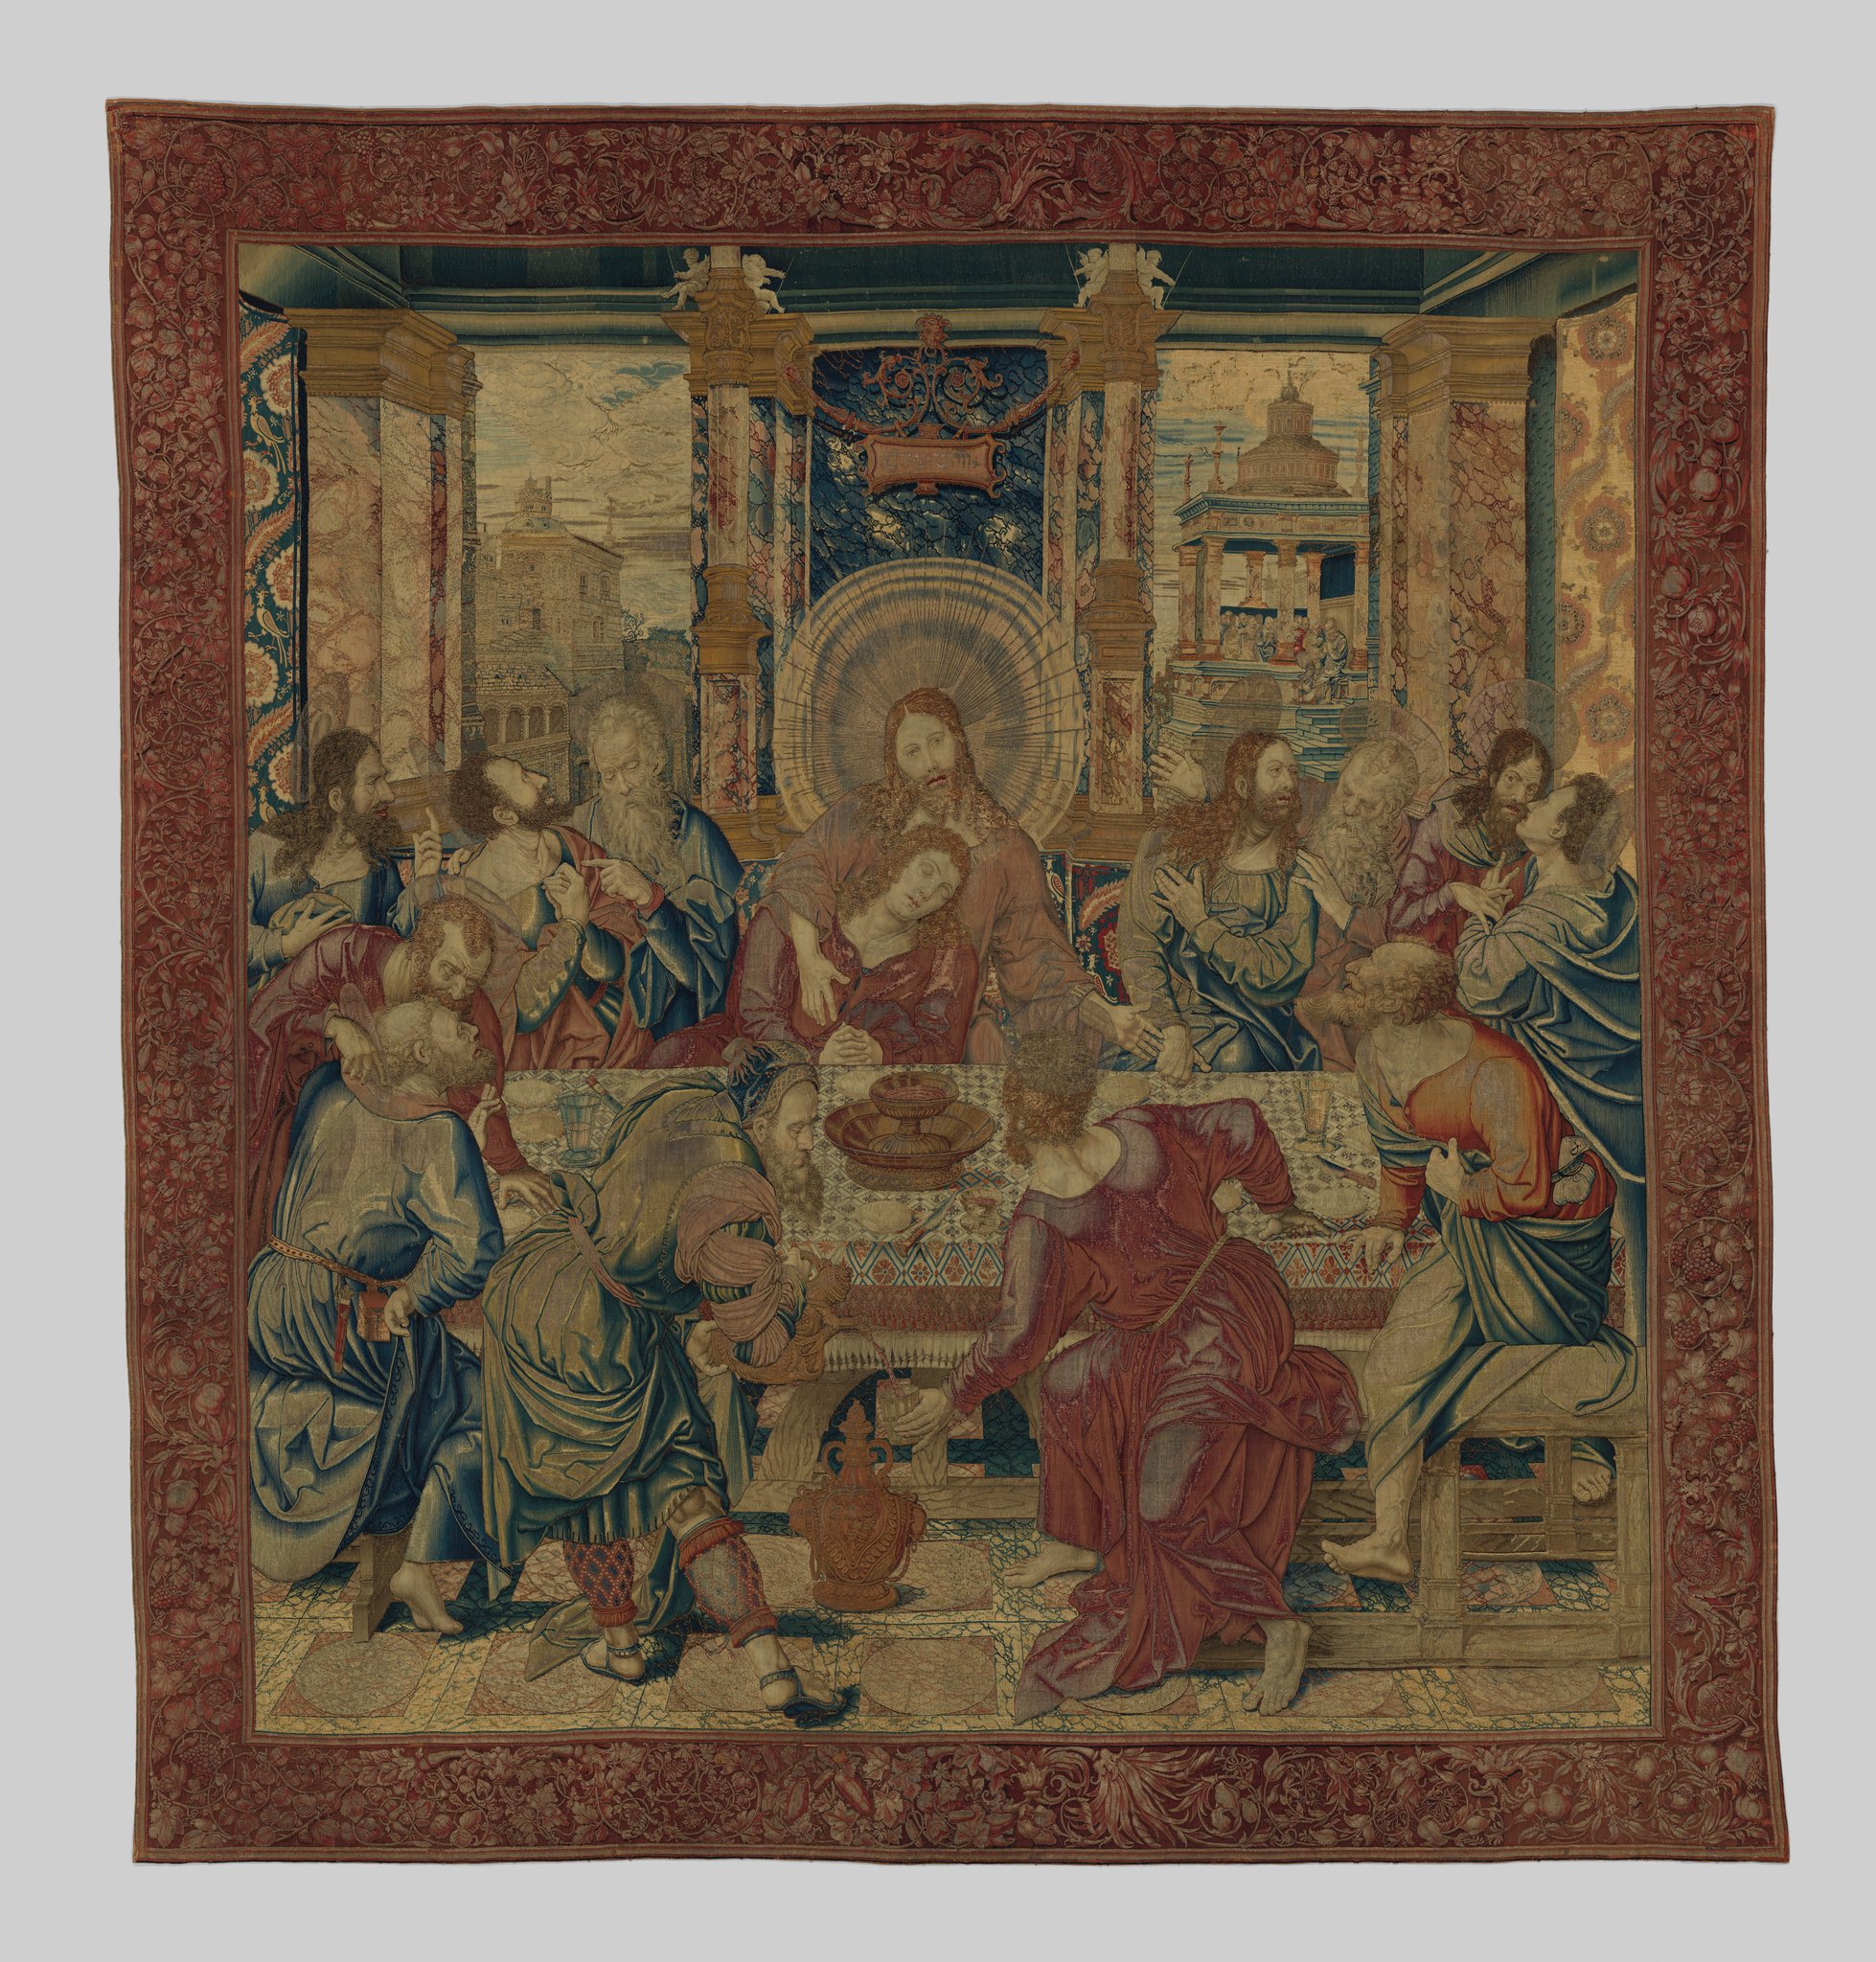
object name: tapestry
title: The Last Supper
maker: bernard van orley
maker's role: artist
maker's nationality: netherlandish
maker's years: 1492-1542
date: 1525-1528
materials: silk, silver gilt, thread, wool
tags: apostles,christ,judas,last supper